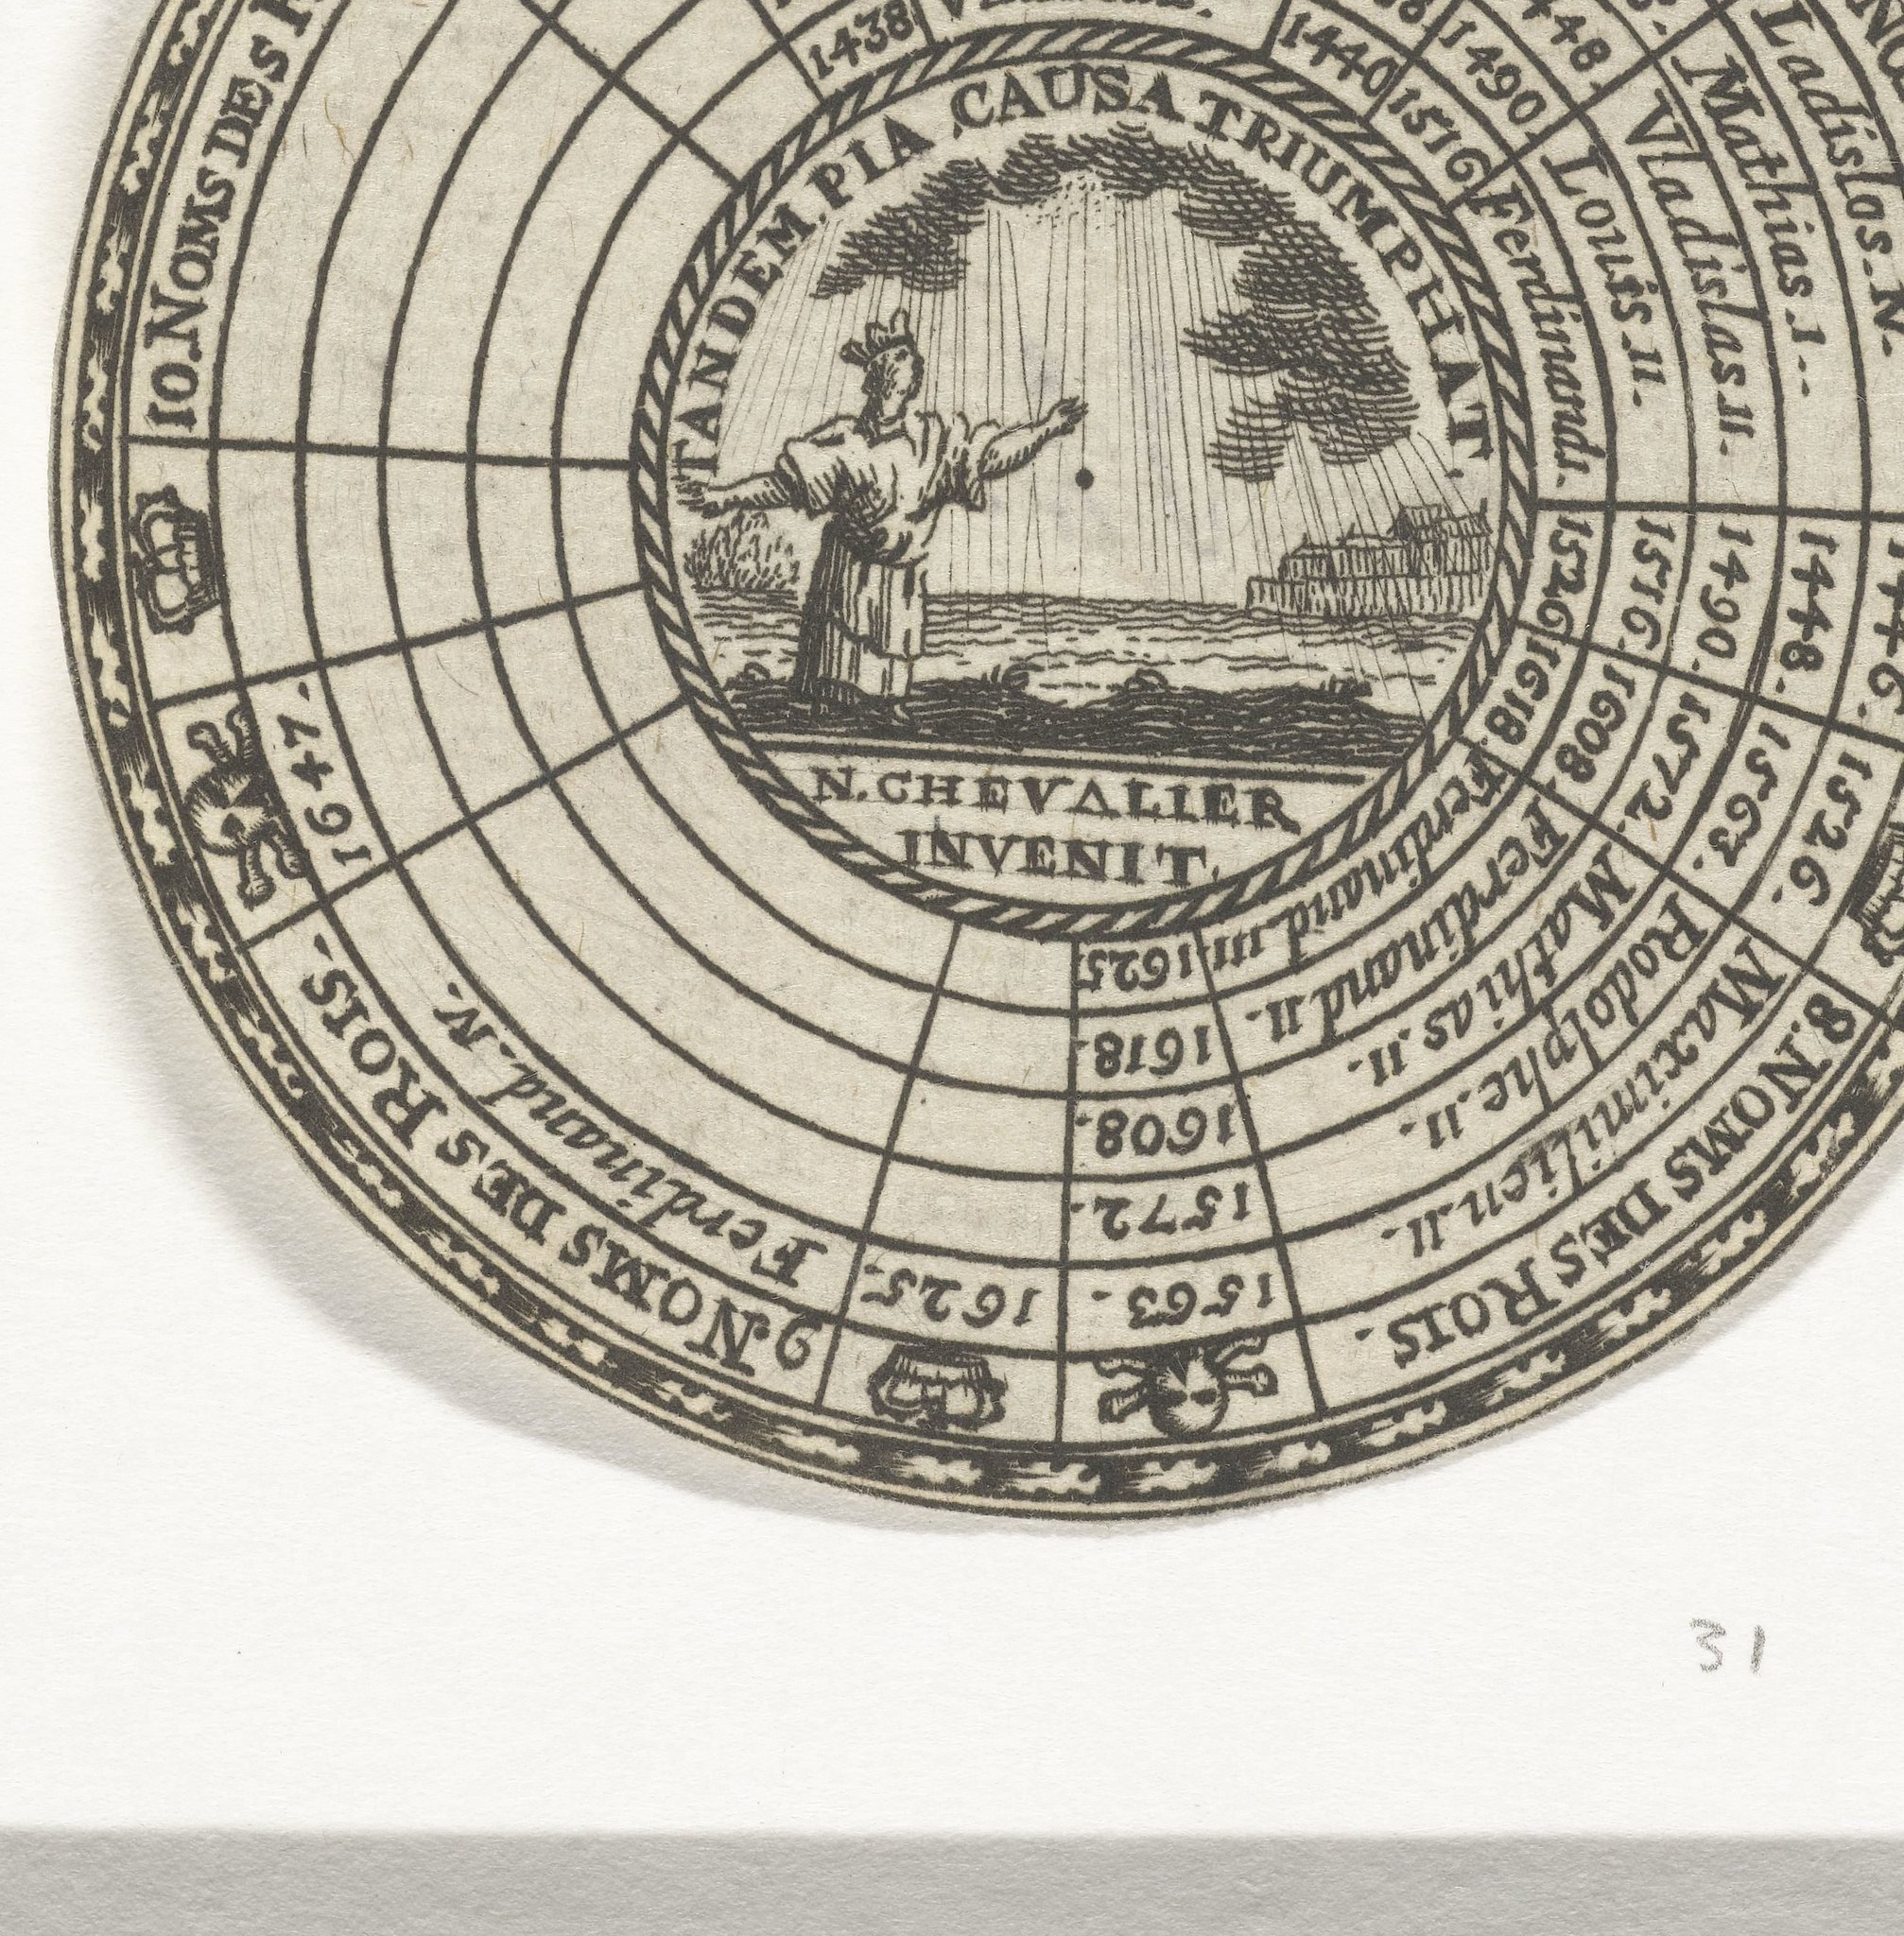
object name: print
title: Penning met een embleem en de namen van de Hongaarse koningen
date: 1711-1720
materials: paper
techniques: etching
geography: amsterdam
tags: vienna, charles vi (holy roman emperor), storm at sea, abstract ideas and concepts (+ emblematical representation of concept), king, seal (symbol of sovereignty)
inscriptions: number: ‘32’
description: Ontwerp van een ronde penning met, in zes concentrische cirkels, de namen van de koningen van Hongarije en hun regeringsjaren, beginnende bij koningin Maria en eindigend bij Ferdinand IV van Hongarije. In het midden van de penning een embleem met een koning die in regenweer door de zee waadt. Het motto van het embleem luidt: "Tandem Pia Causa Triumphat".